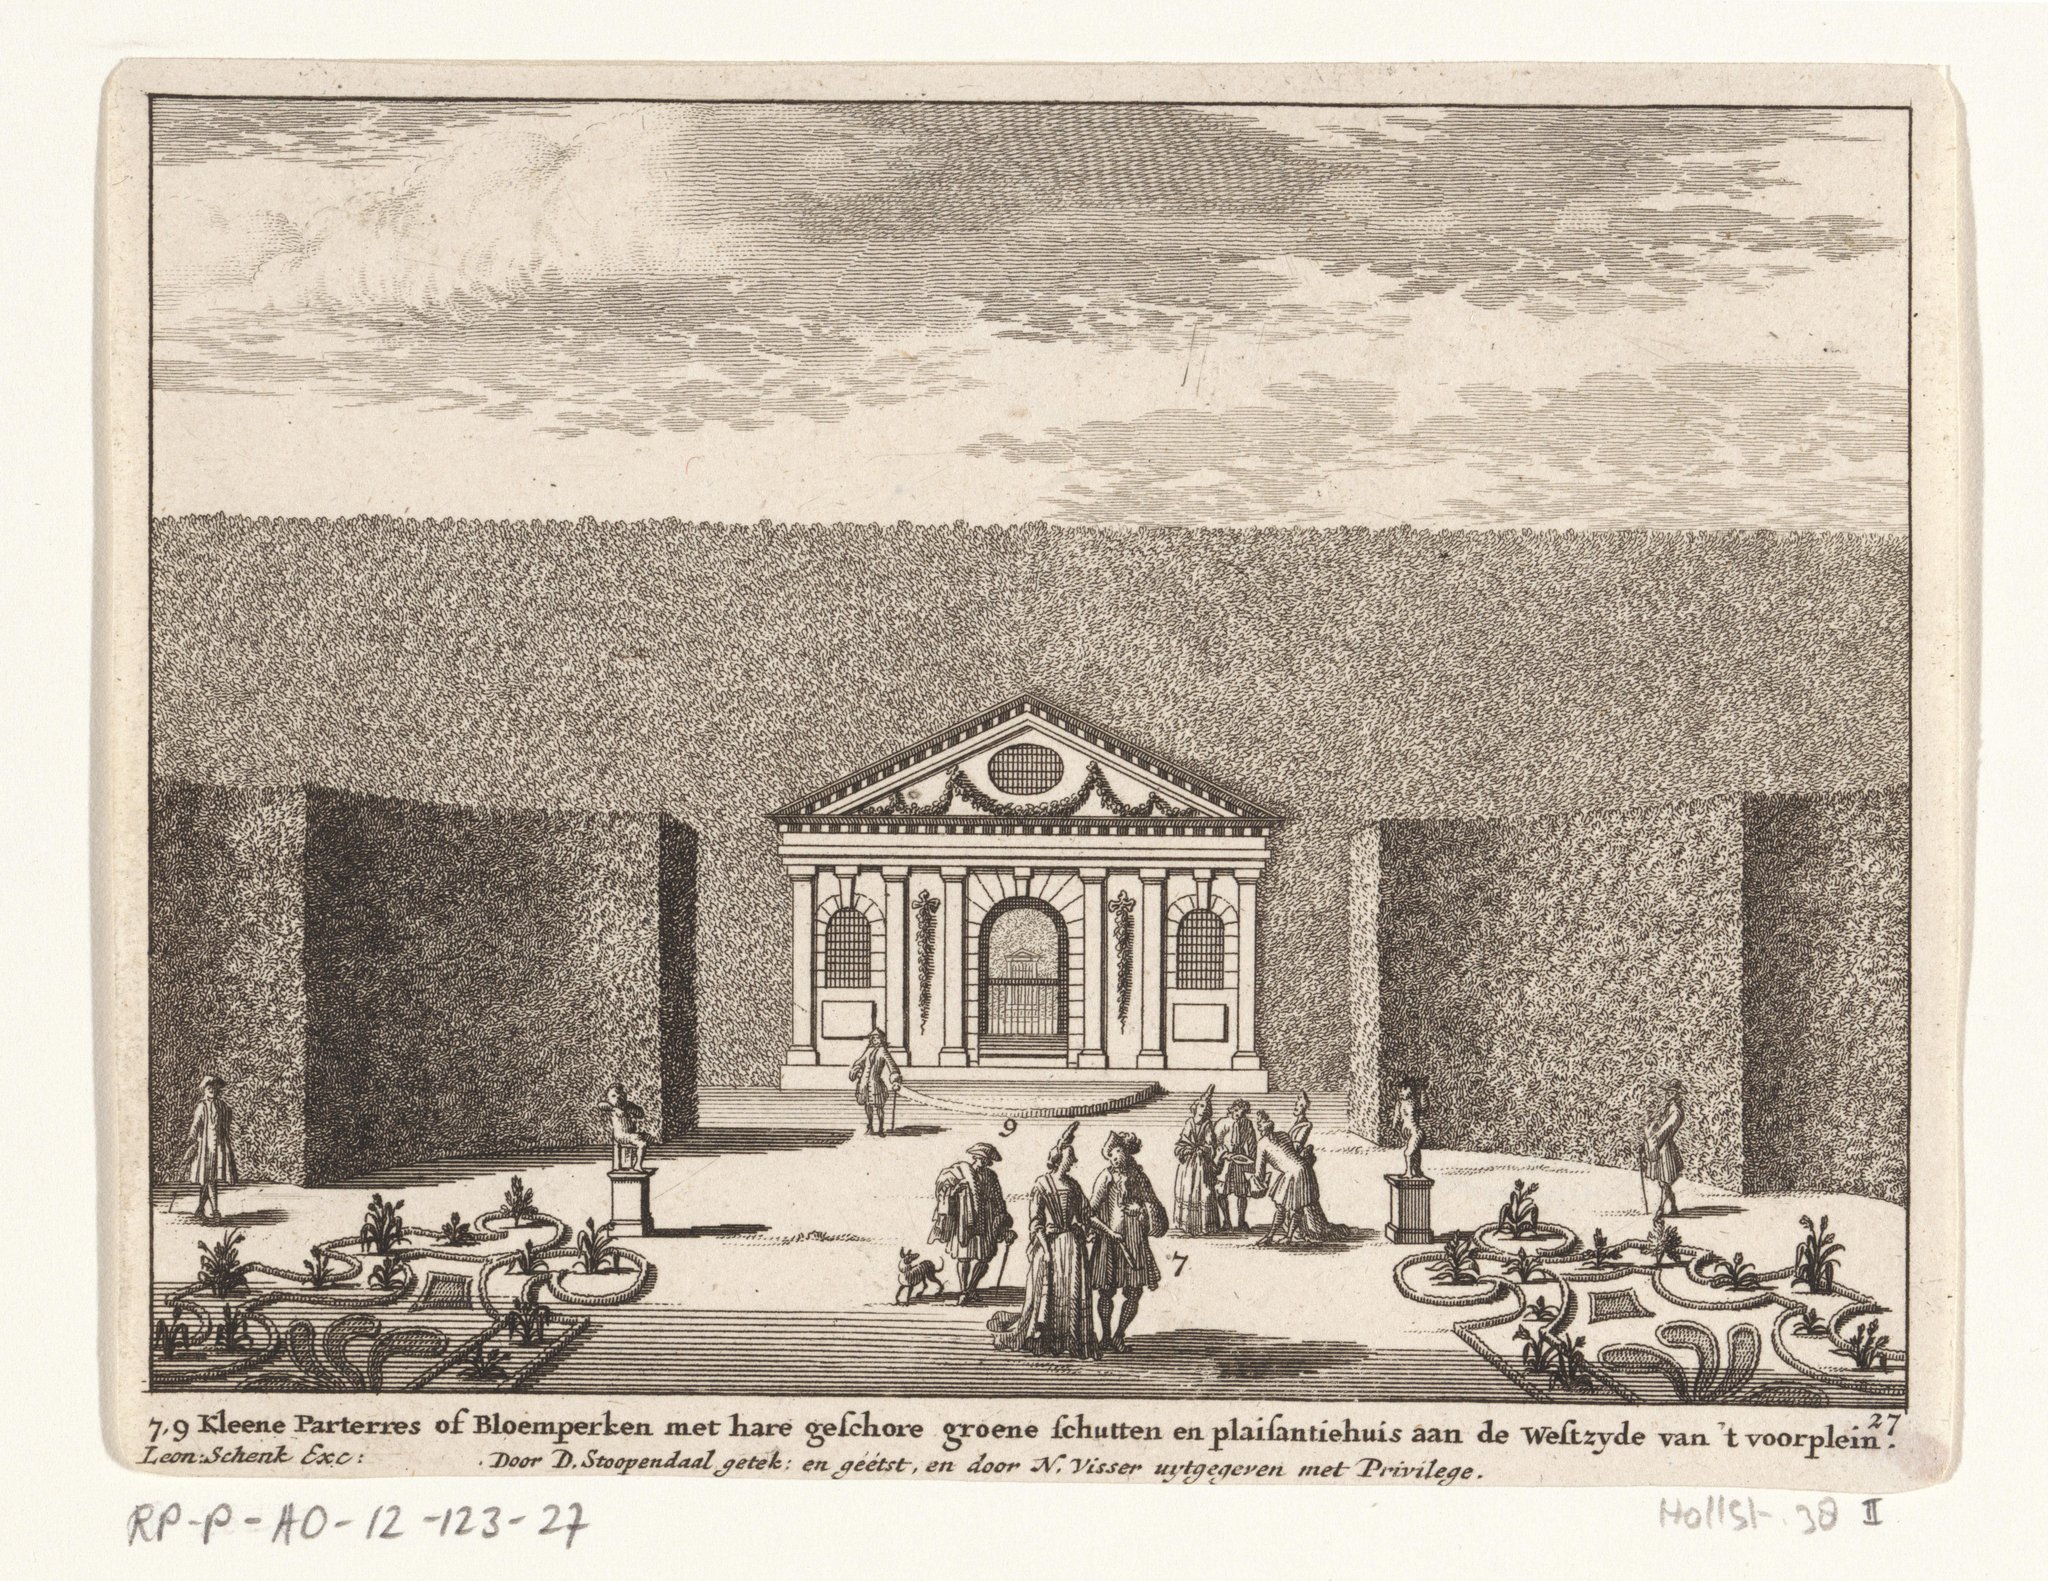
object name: print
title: Kleene Parterres of Bloemperken met hare geschore groene schutten en plaisantiehuis aan de Westzyde van 't voorplein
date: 1682-1726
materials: paper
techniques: etching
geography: amsterdam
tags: french or architectonic garden; formal garden, garden buildings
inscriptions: collector's mark: Lugt 2228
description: Gezicht op een deel van de tuinen met het tuinhuis op landgoed Clingendael te Den Haag. In de tuin lopen elegante figuren.